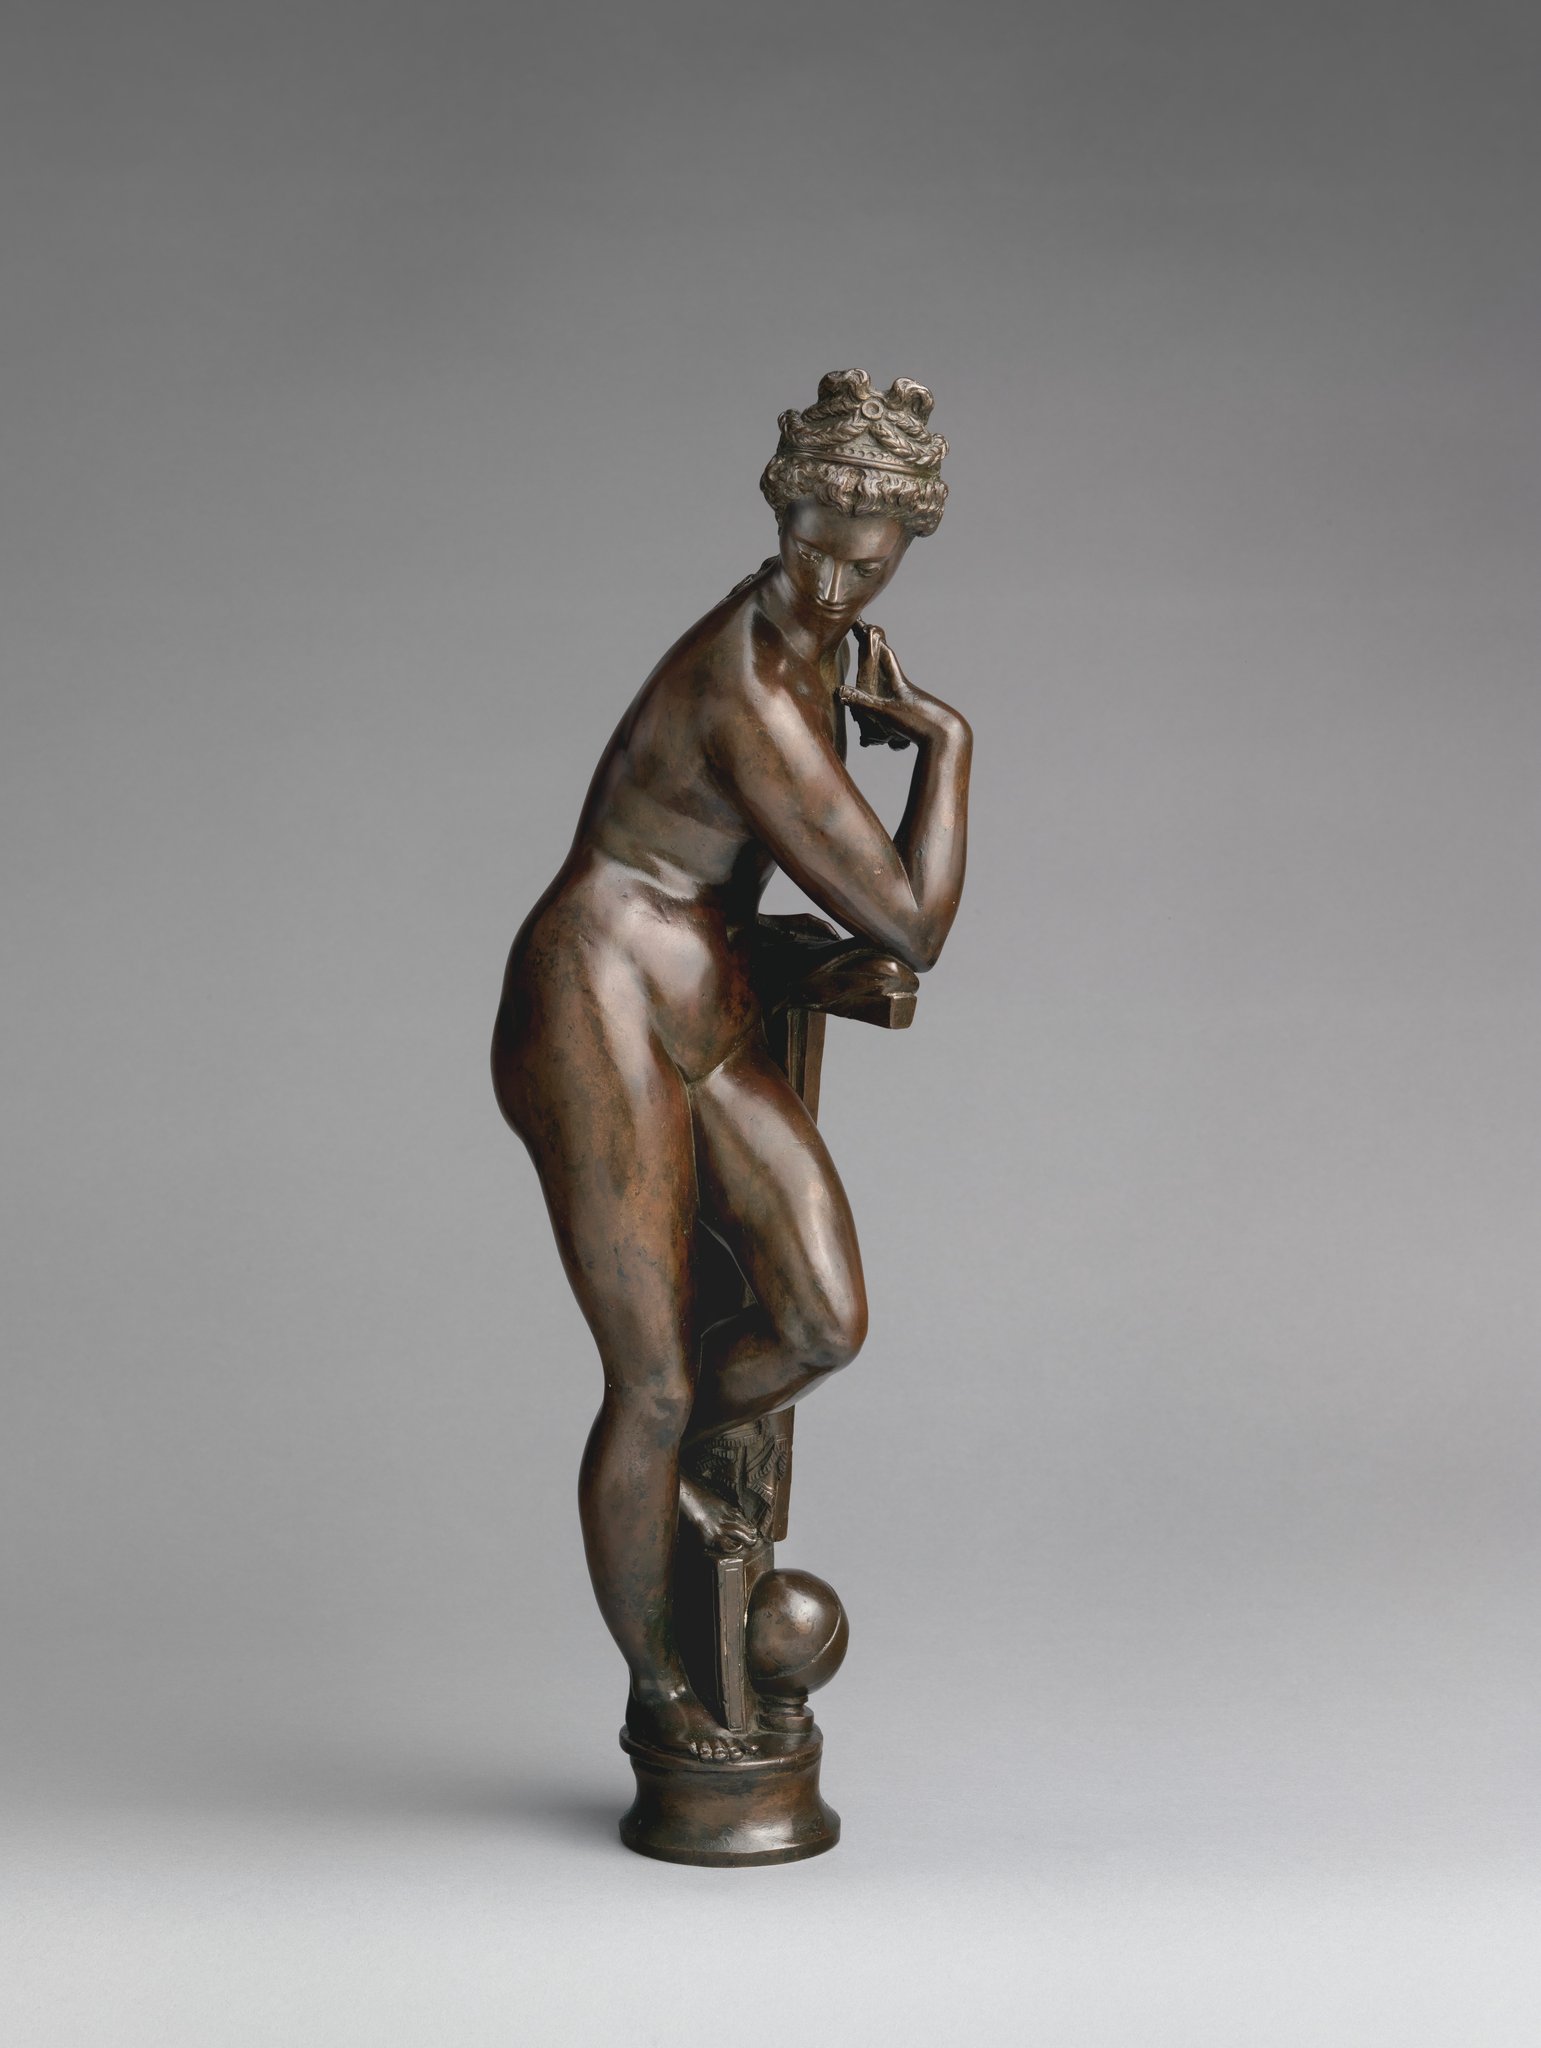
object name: statuette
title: Astronomy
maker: giambologna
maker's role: artist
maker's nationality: netherlandish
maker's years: 1529-1608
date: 1601-1700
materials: bronze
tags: female nudes,astronomy